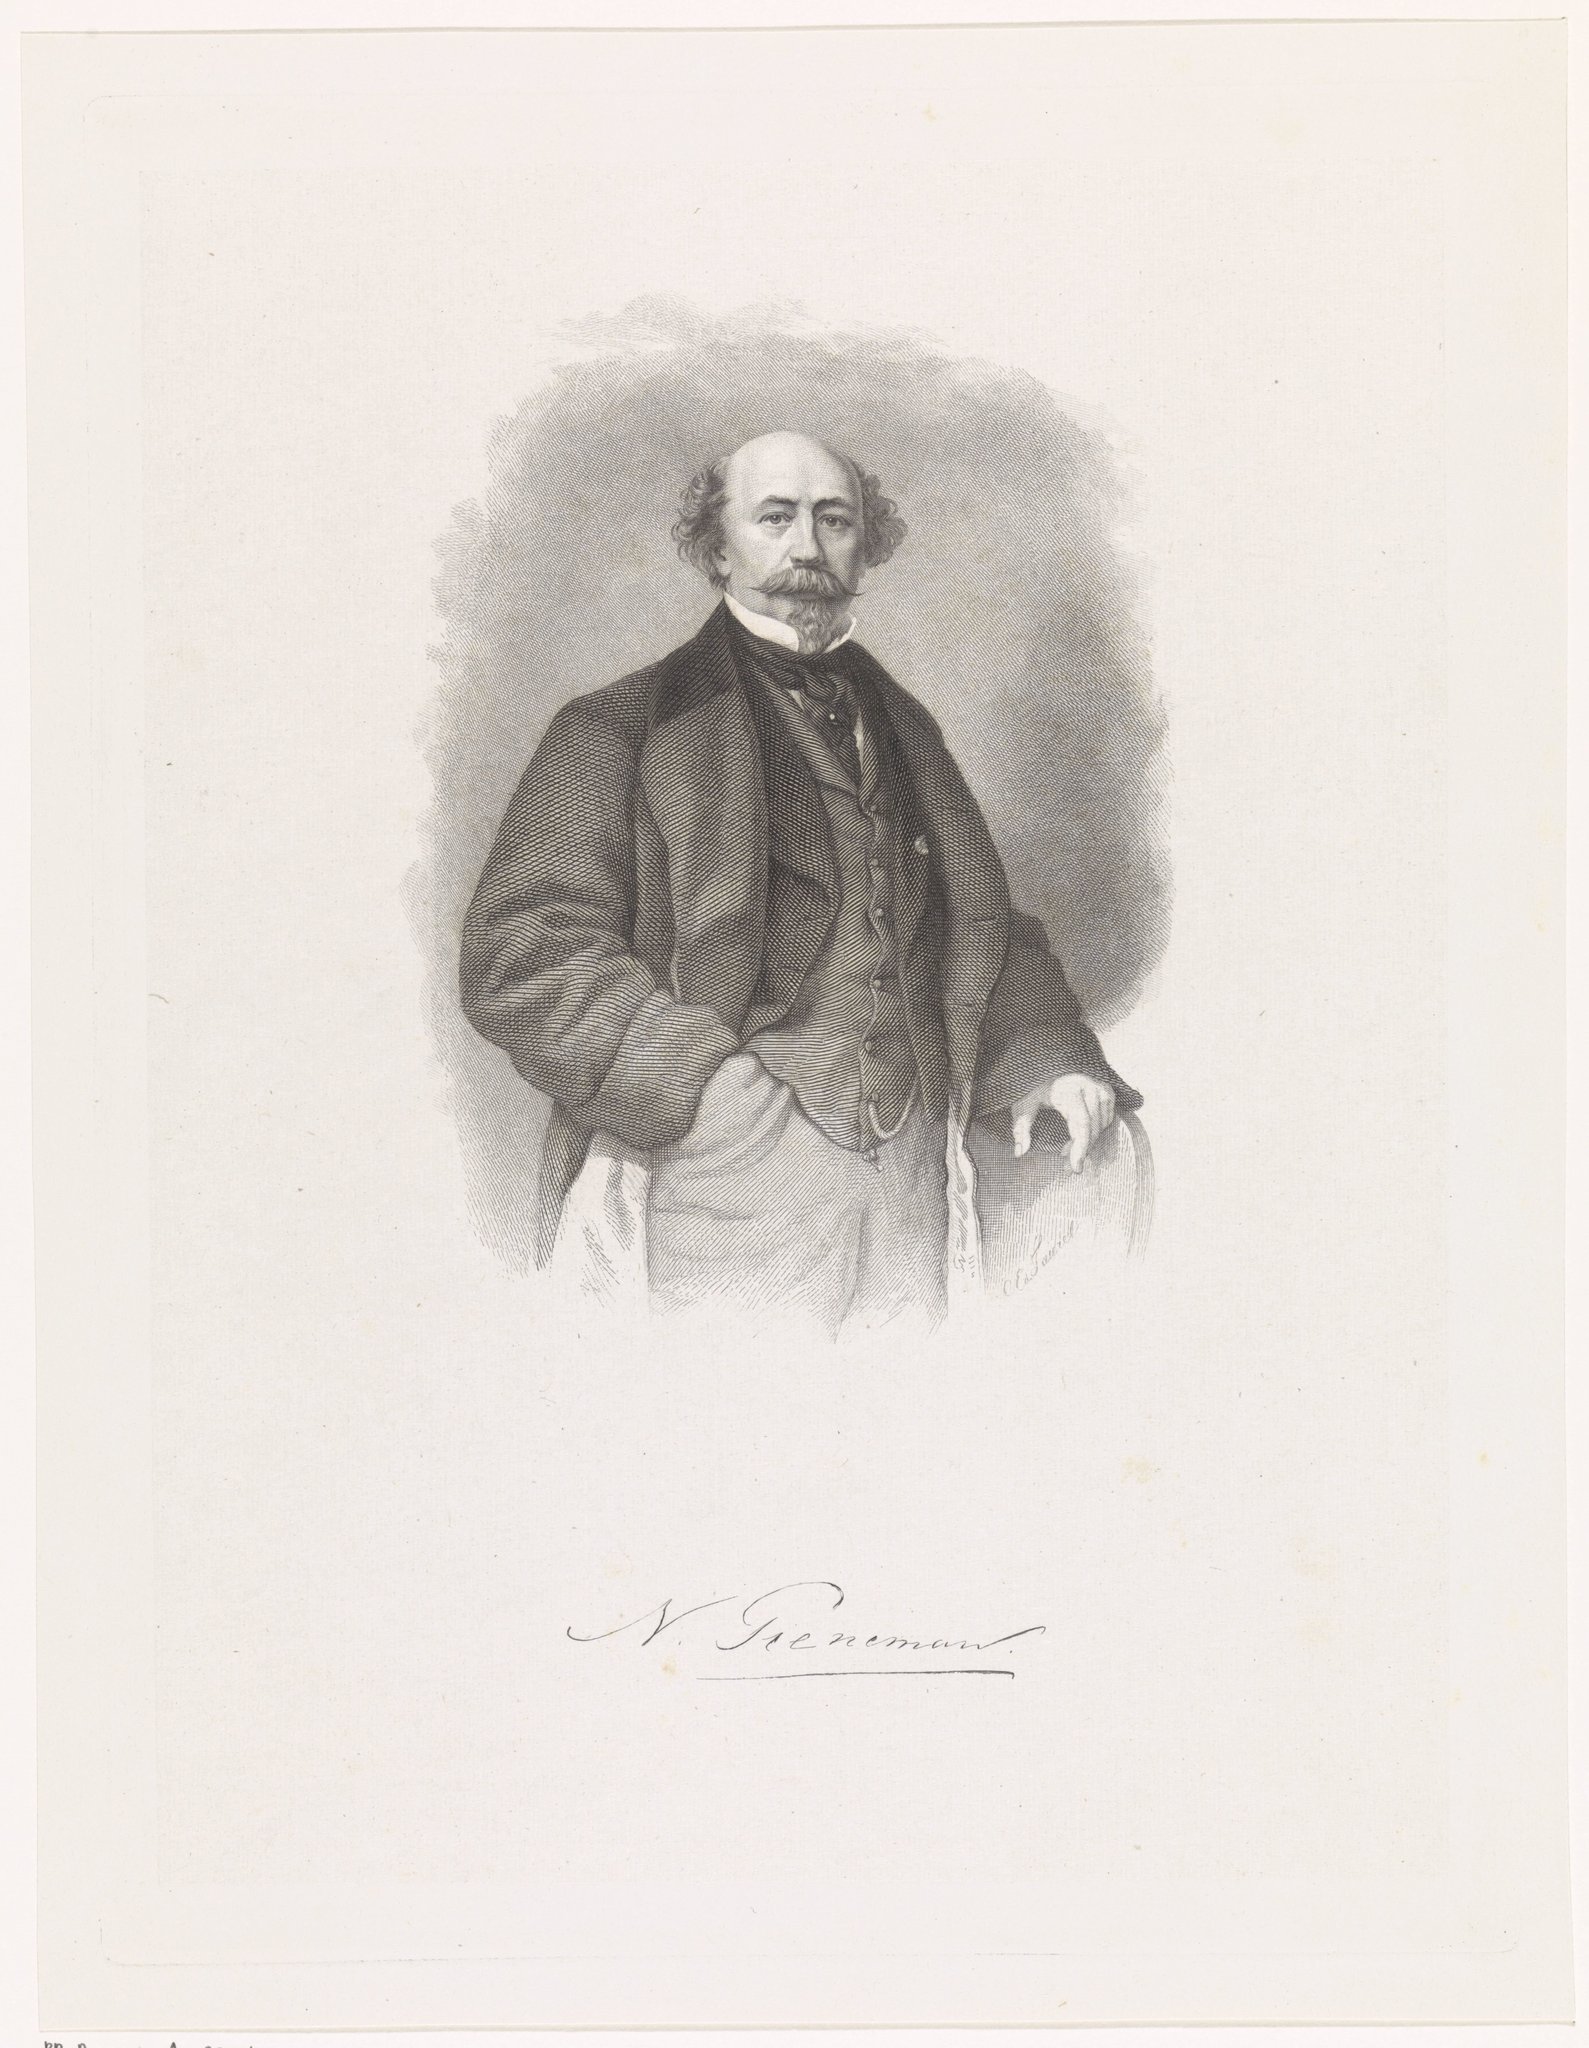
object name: print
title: Portret van Nicolaas Pieneman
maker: edouard taurel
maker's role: draughtsman, print maker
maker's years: 1824-1892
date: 1834-1891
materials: paper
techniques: engraving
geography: amsterdam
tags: painter, nicolaas pieneman, historical persons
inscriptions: collector's mark: Lugt 2228